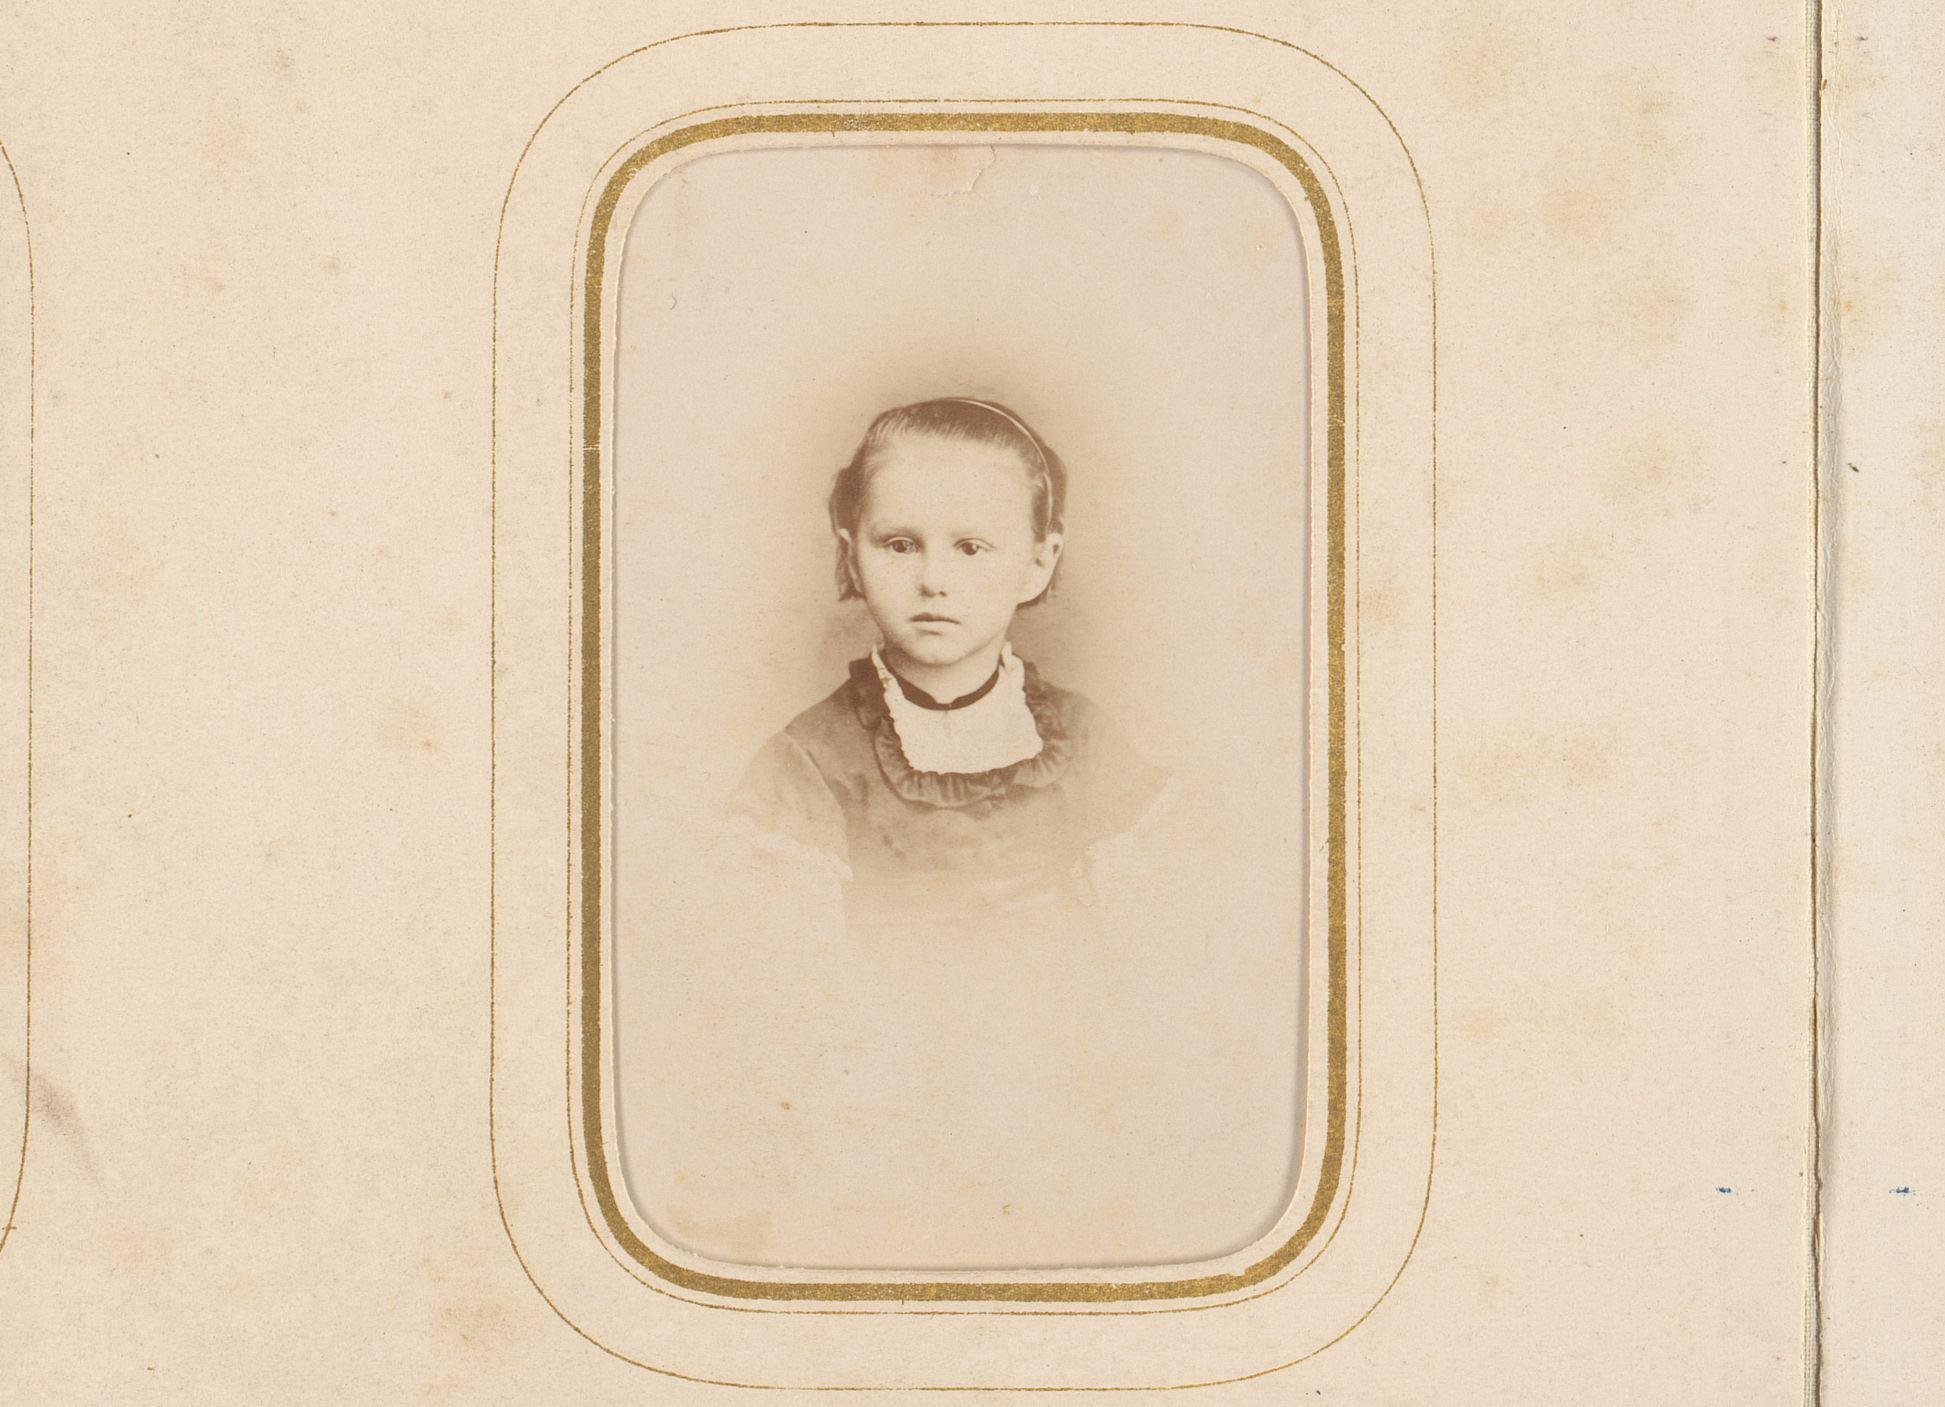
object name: photograph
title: Portret van een meisje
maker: alphonse bernoud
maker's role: fotograaf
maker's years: 1820-1889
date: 1868-1889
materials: cardboard, photographic support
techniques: albumen print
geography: france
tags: girl (child between toddler and youth)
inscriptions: inscription: ‘Alphonse Bernoud/ Photographe/ Florence Via dell'Orivolo, 51/ Livourne/ Via Vitt. Emman le 71/ Naples Strada Toledo 256/ Palazzo Berio/ Lyon/ 2, Rue des Archers, 2/ Angle de la Rue St. Dominique’